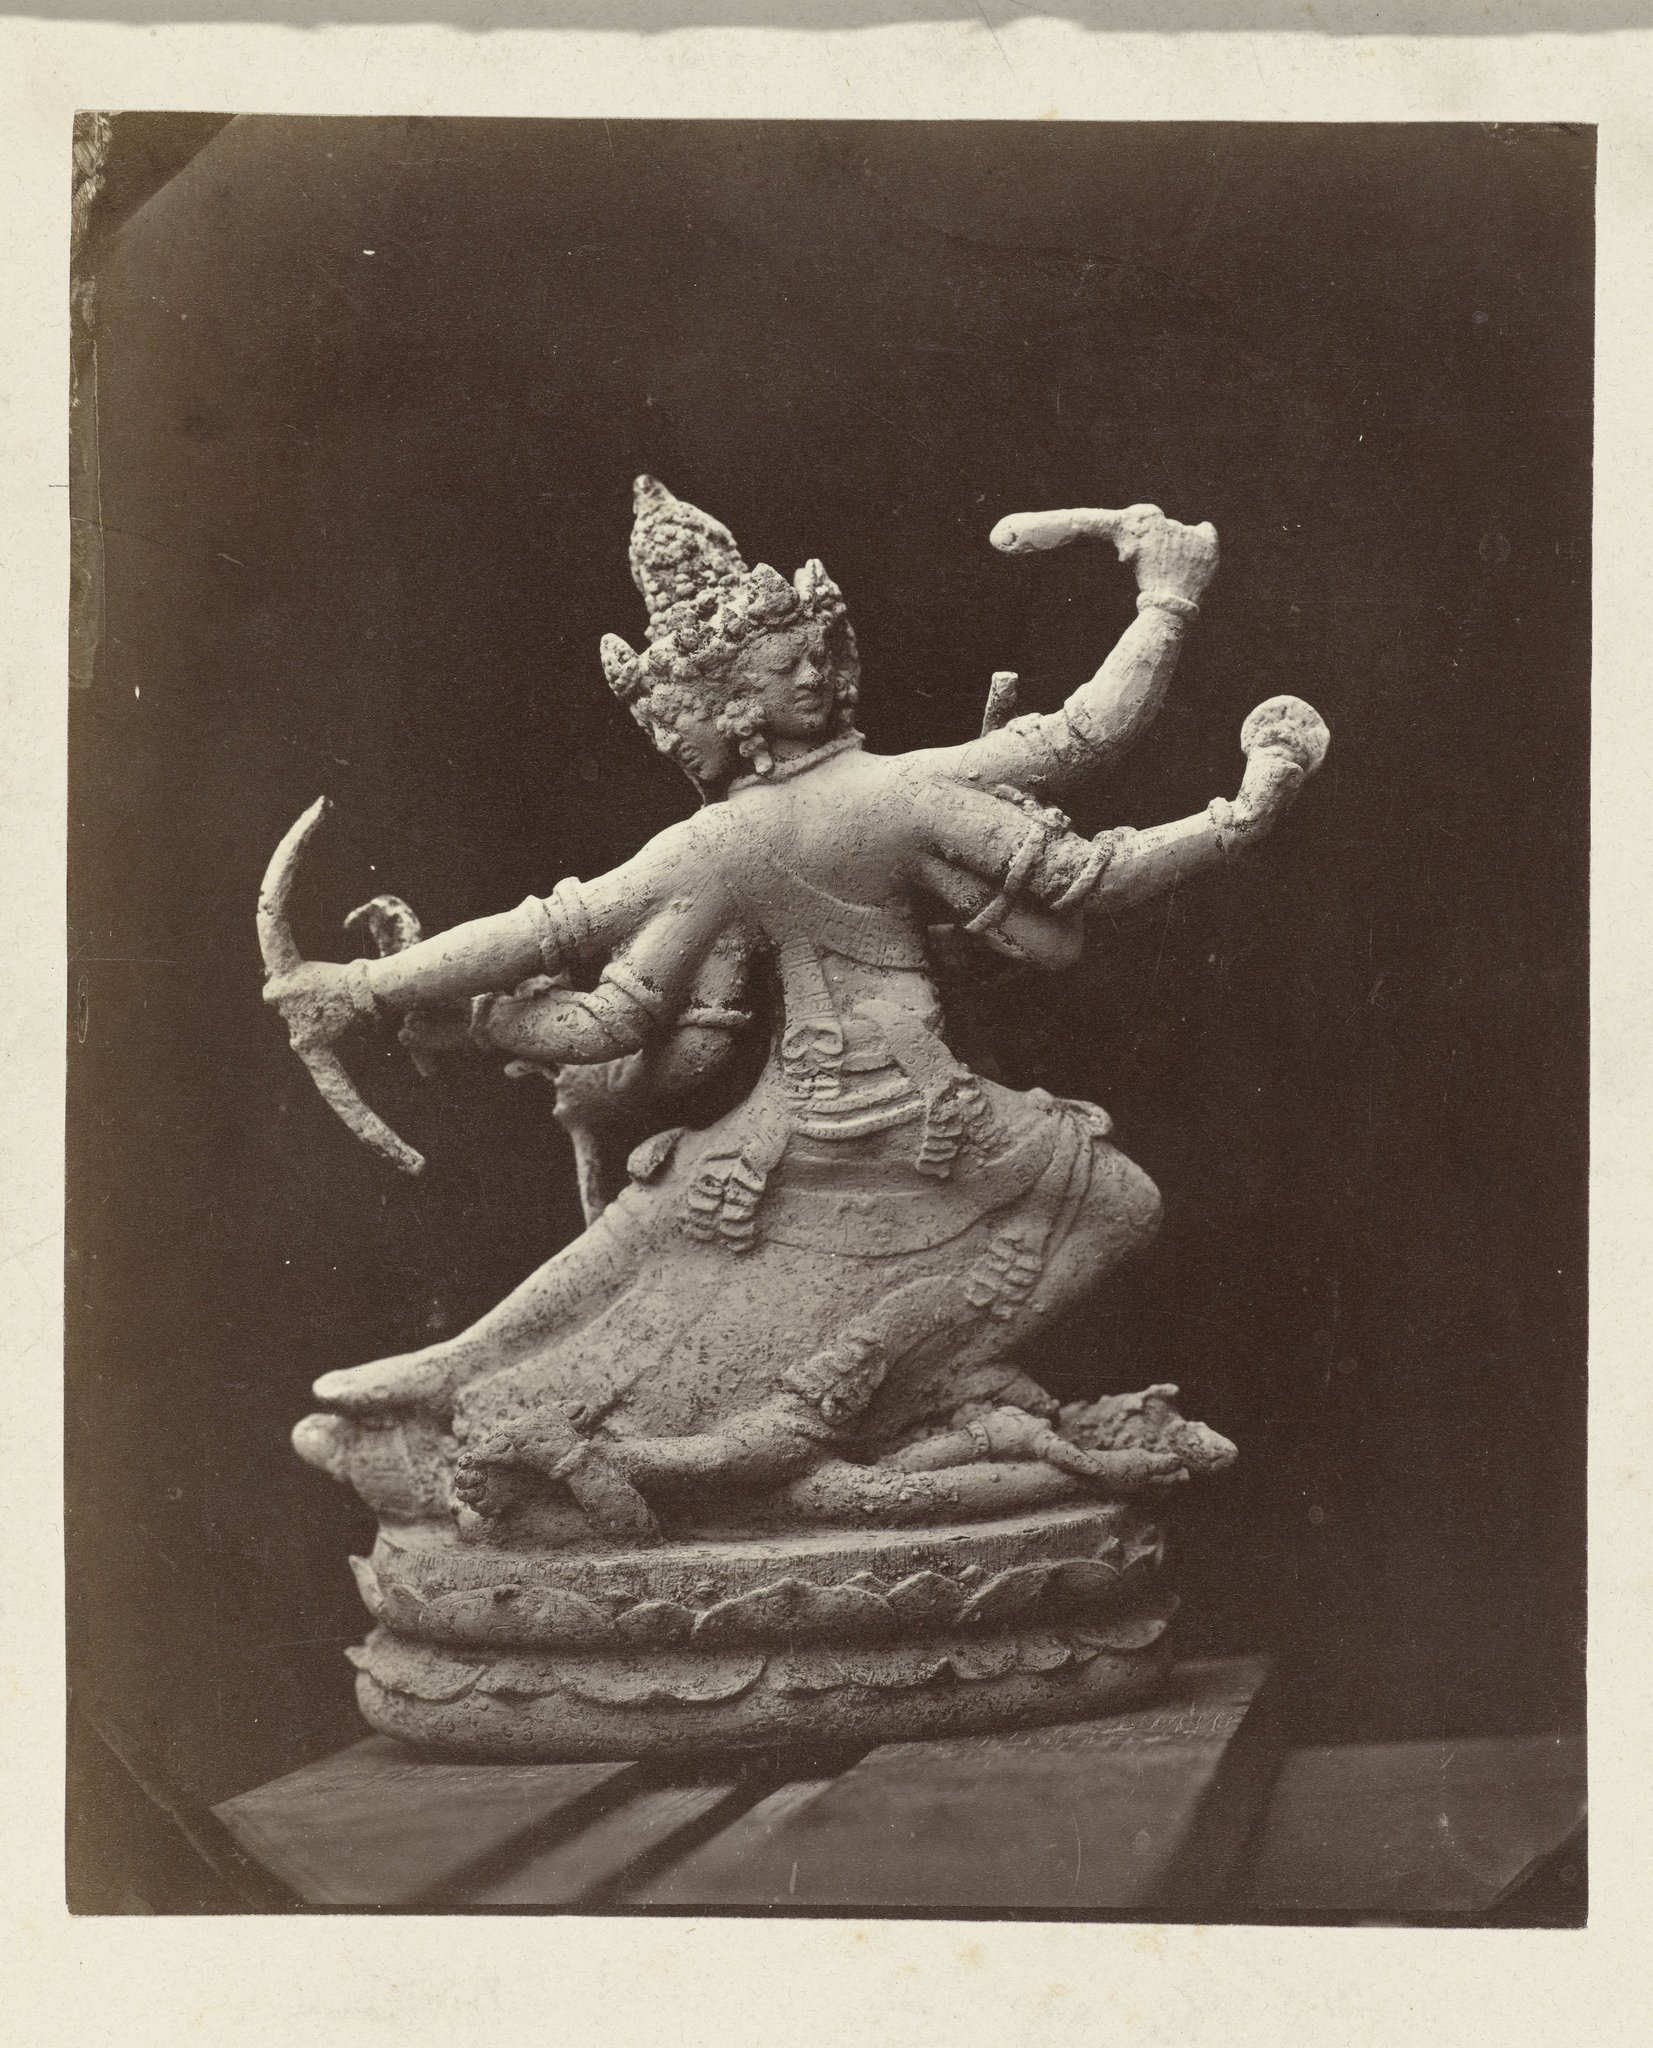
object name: photograph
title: Djokjokarta (Klaring) (r. Djokjokarta) Eight-armed bronze Trailokyavijaya dashing a corpse (Former Klaring collection). Yogyakarta, Yogyakarta district, D.I. Yogyakarta province, 9th-10th century.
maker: isidore kinsbergen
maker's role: fotograaf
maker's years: 1821-1905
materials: cardboard, paper, photographic support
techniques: albumen print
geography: java